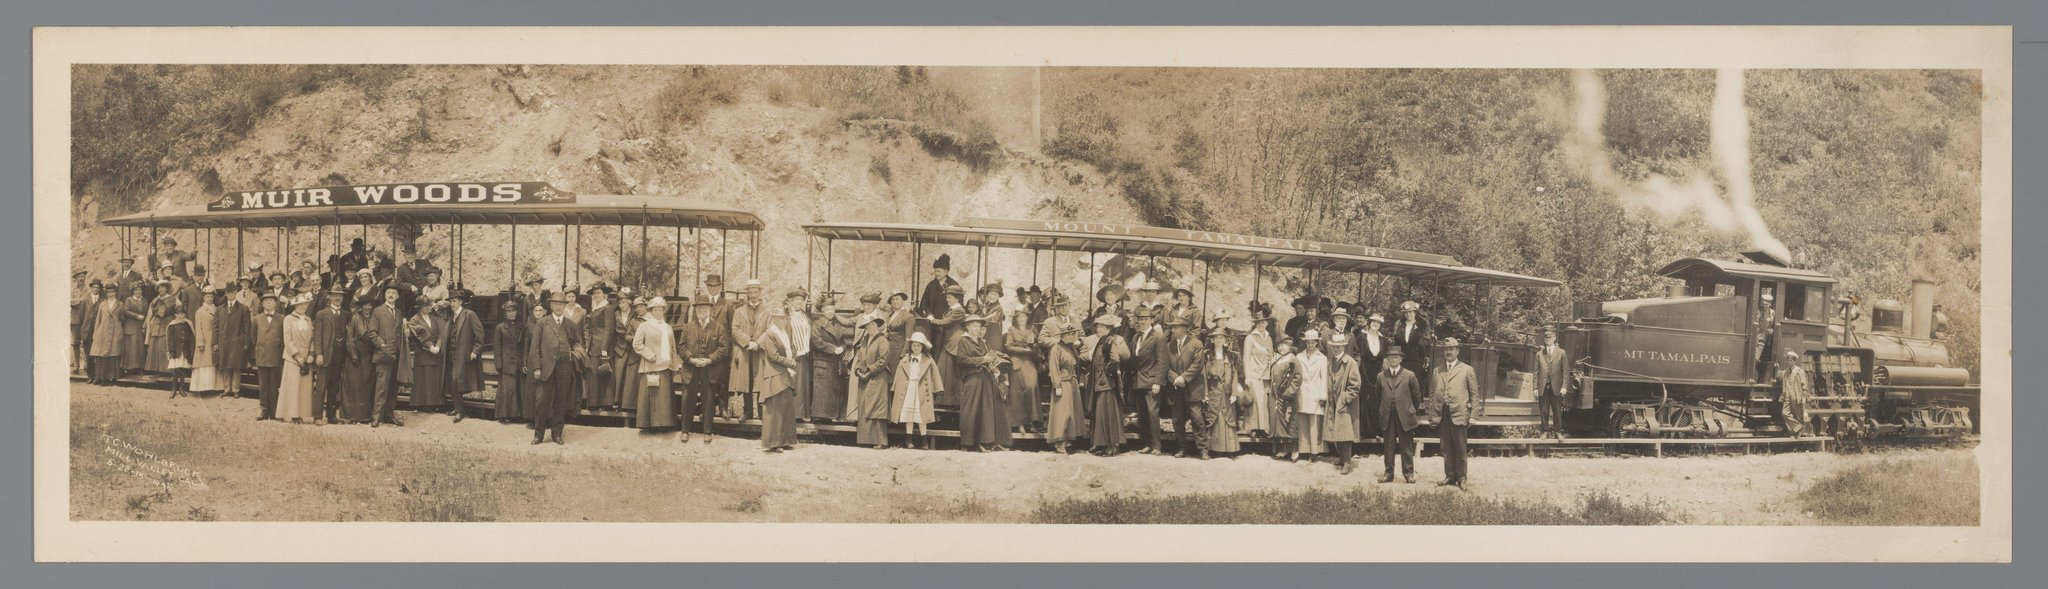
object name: photograph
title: Witsen en Marie Witsen met groep voor stoomtrein (Californië)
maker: Anonymous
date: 1860-1915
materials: paper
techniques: gelatin silver print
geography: california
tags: print maker, draughtsman, willem witsen, augusta maria agnes witsen-schorr